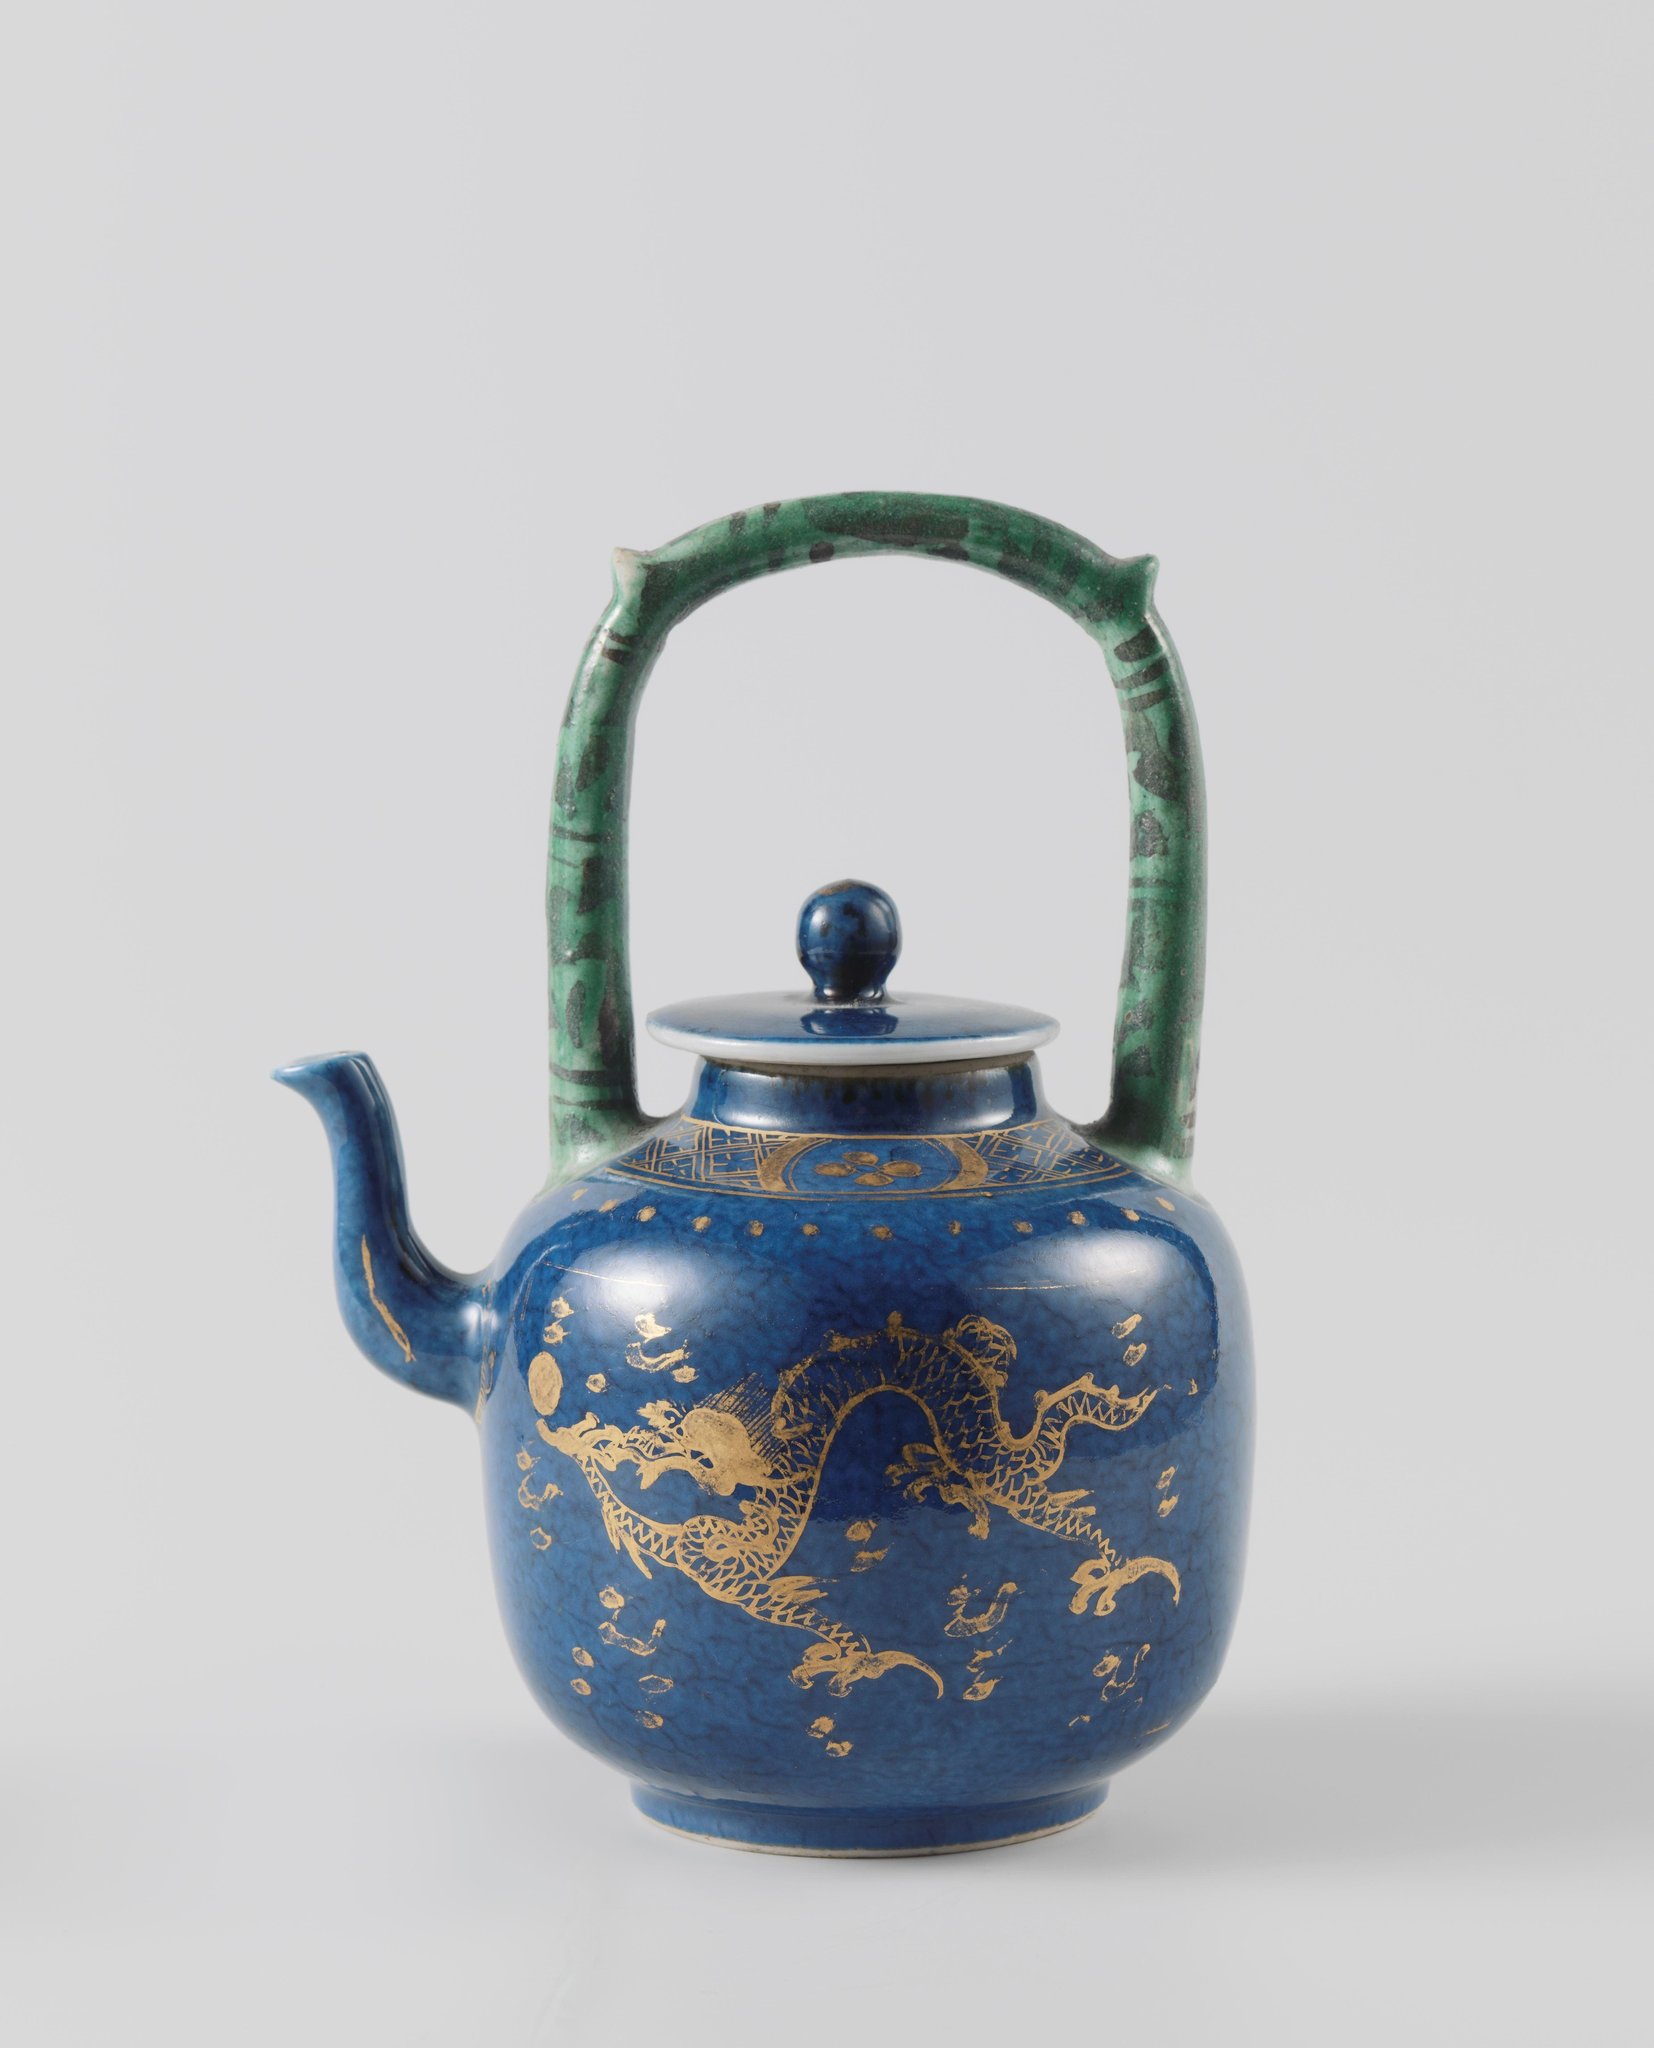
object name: teapot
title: Teapot with powder blue and pearl chasing dragons in gold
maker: Anonymous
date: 1700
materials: glaze, gold, paint, porcelain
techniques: firing, forming, gilding, turning, vitrification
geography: china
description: Trekpot, bleu poudré, met draken en lijnornament in goud, hengsel.